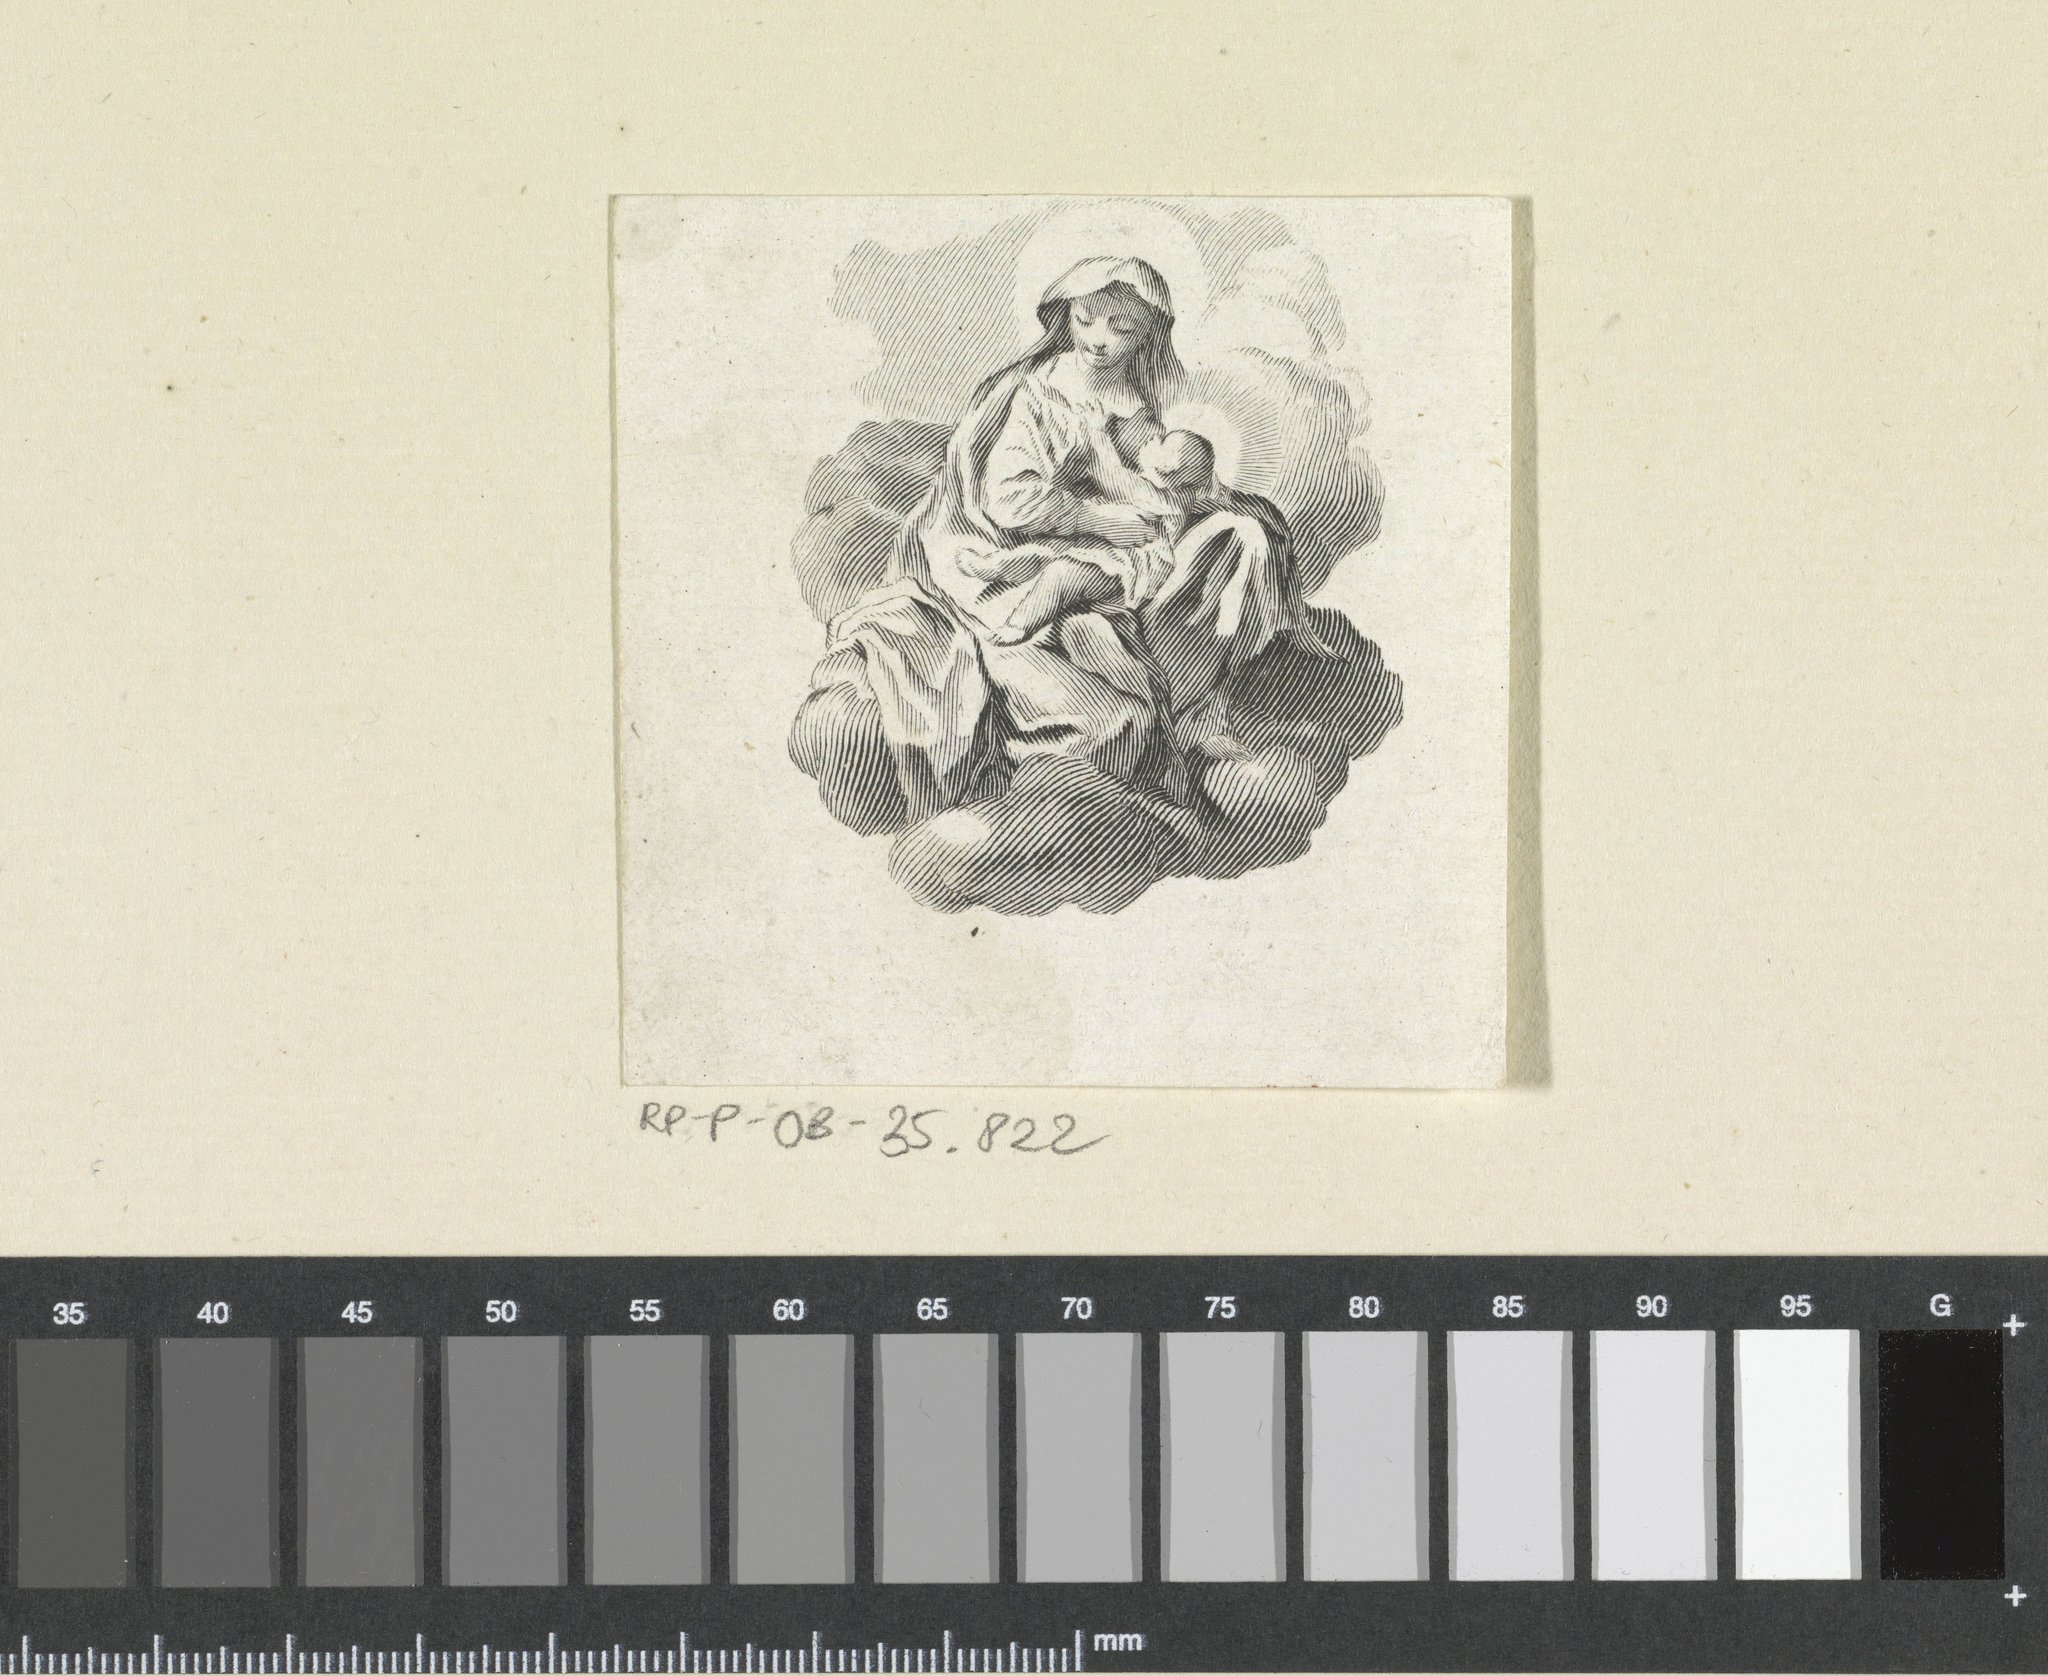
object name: print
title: Maria het Christuskind voedend op een wolk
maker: giovanni cattini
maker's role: print maker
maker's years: 1725-1800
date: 1735-1800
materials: paper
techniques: engraving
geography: italy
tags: madonna: i.e. mary with the christ-child, 'madonna dell'umiltà' (usually mary suckling the christ-child while sitting on the ground)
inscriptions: collector's mark: Lugt 240